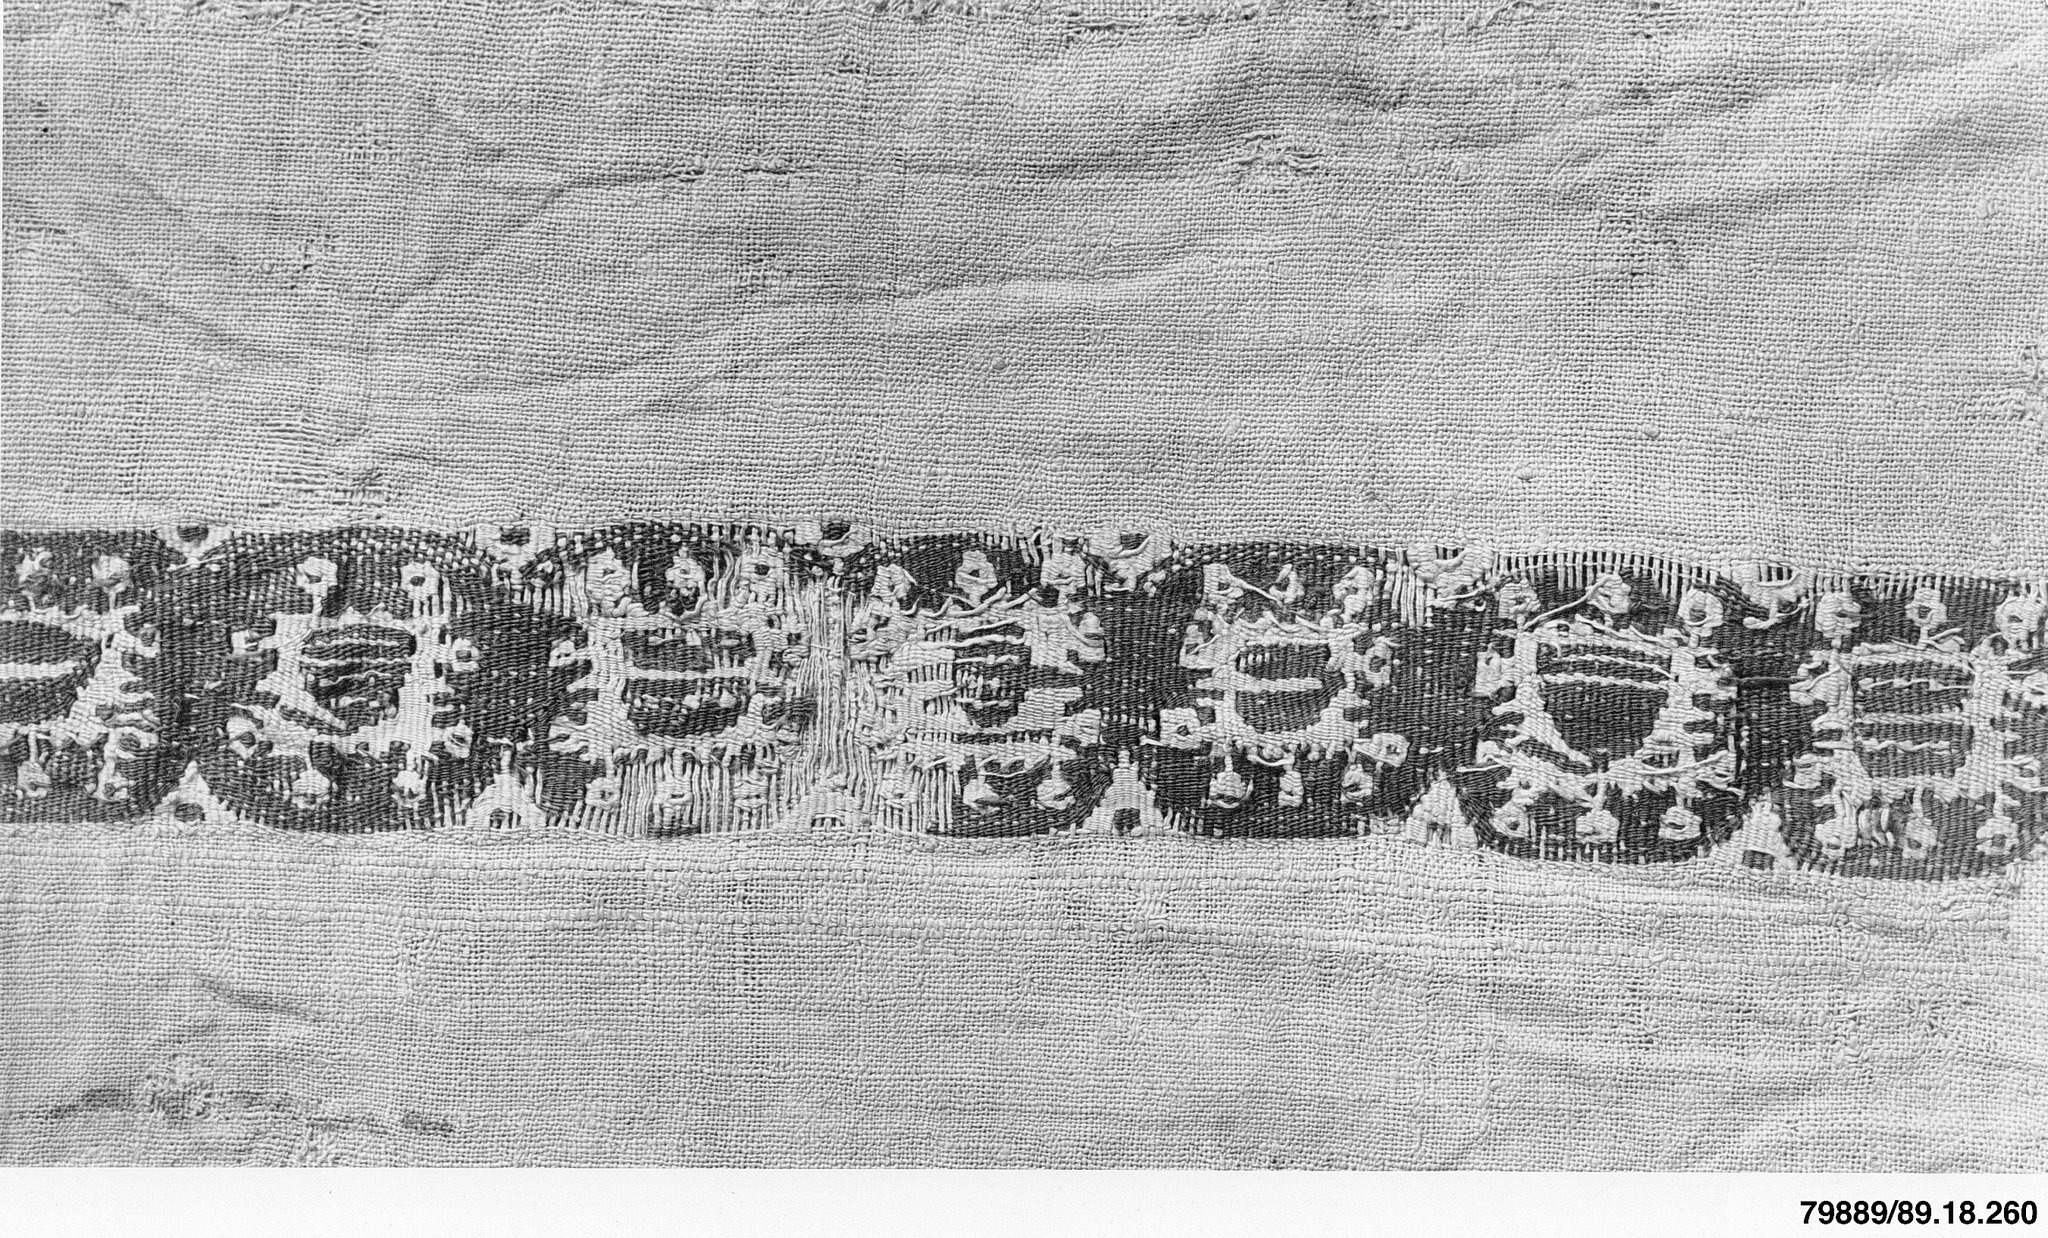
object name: textile fragment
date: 301-400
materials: linen, wool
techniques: weave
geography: egypt